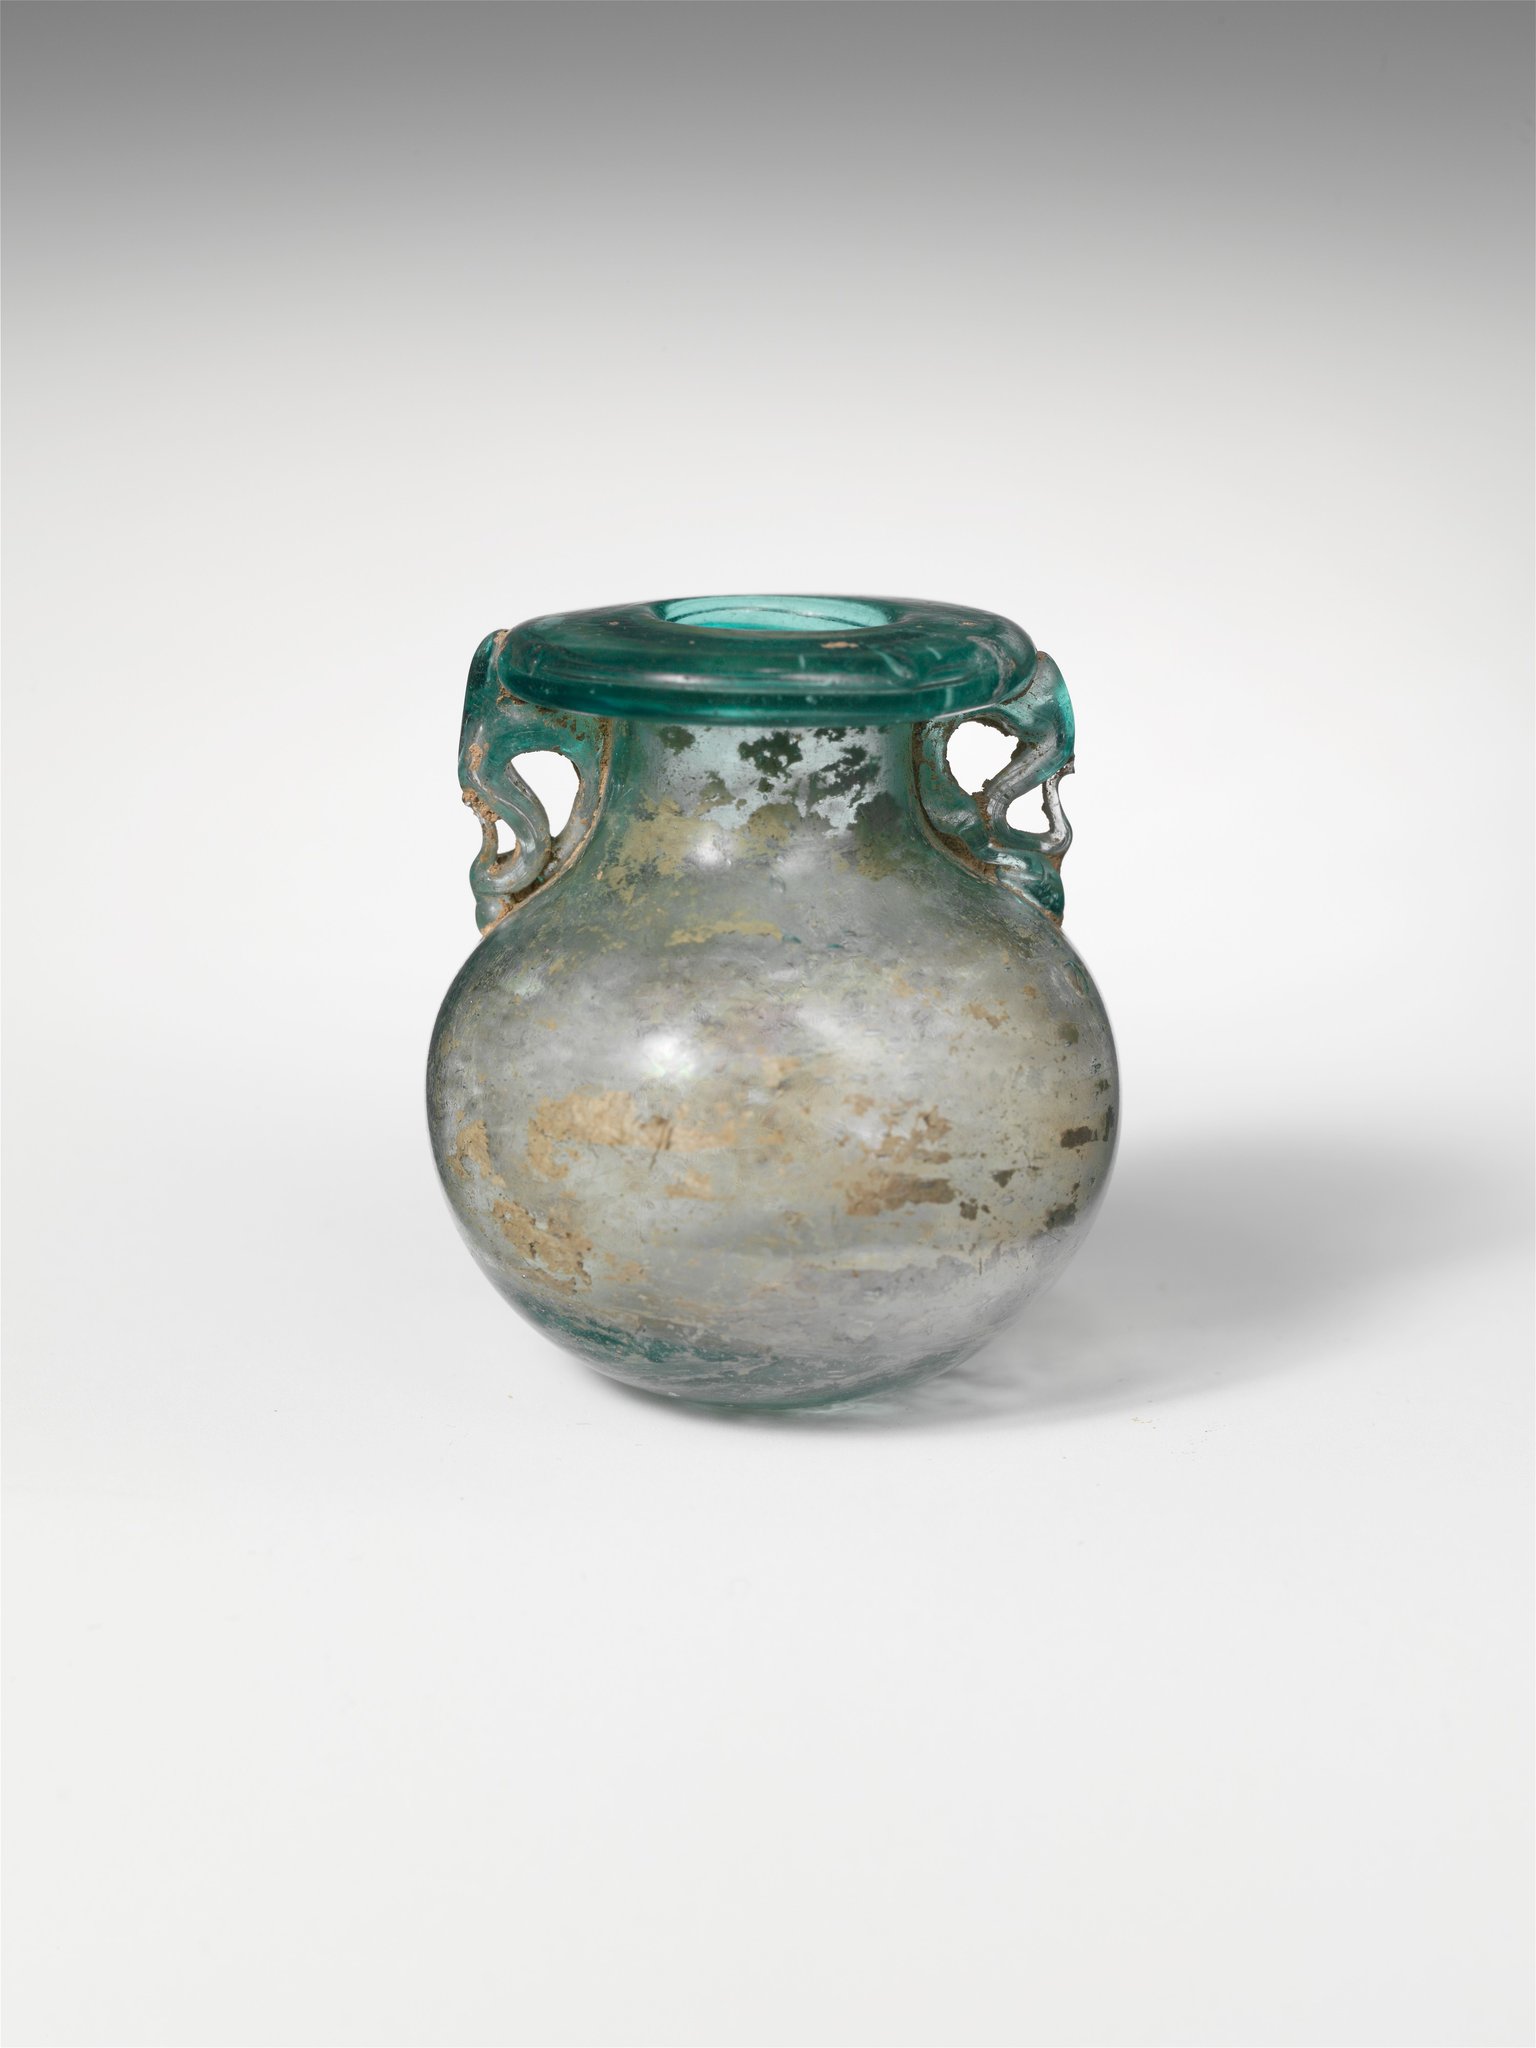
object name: aryballos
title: Glass aryballos (oil bottle)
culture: roman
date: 1-300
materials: glass